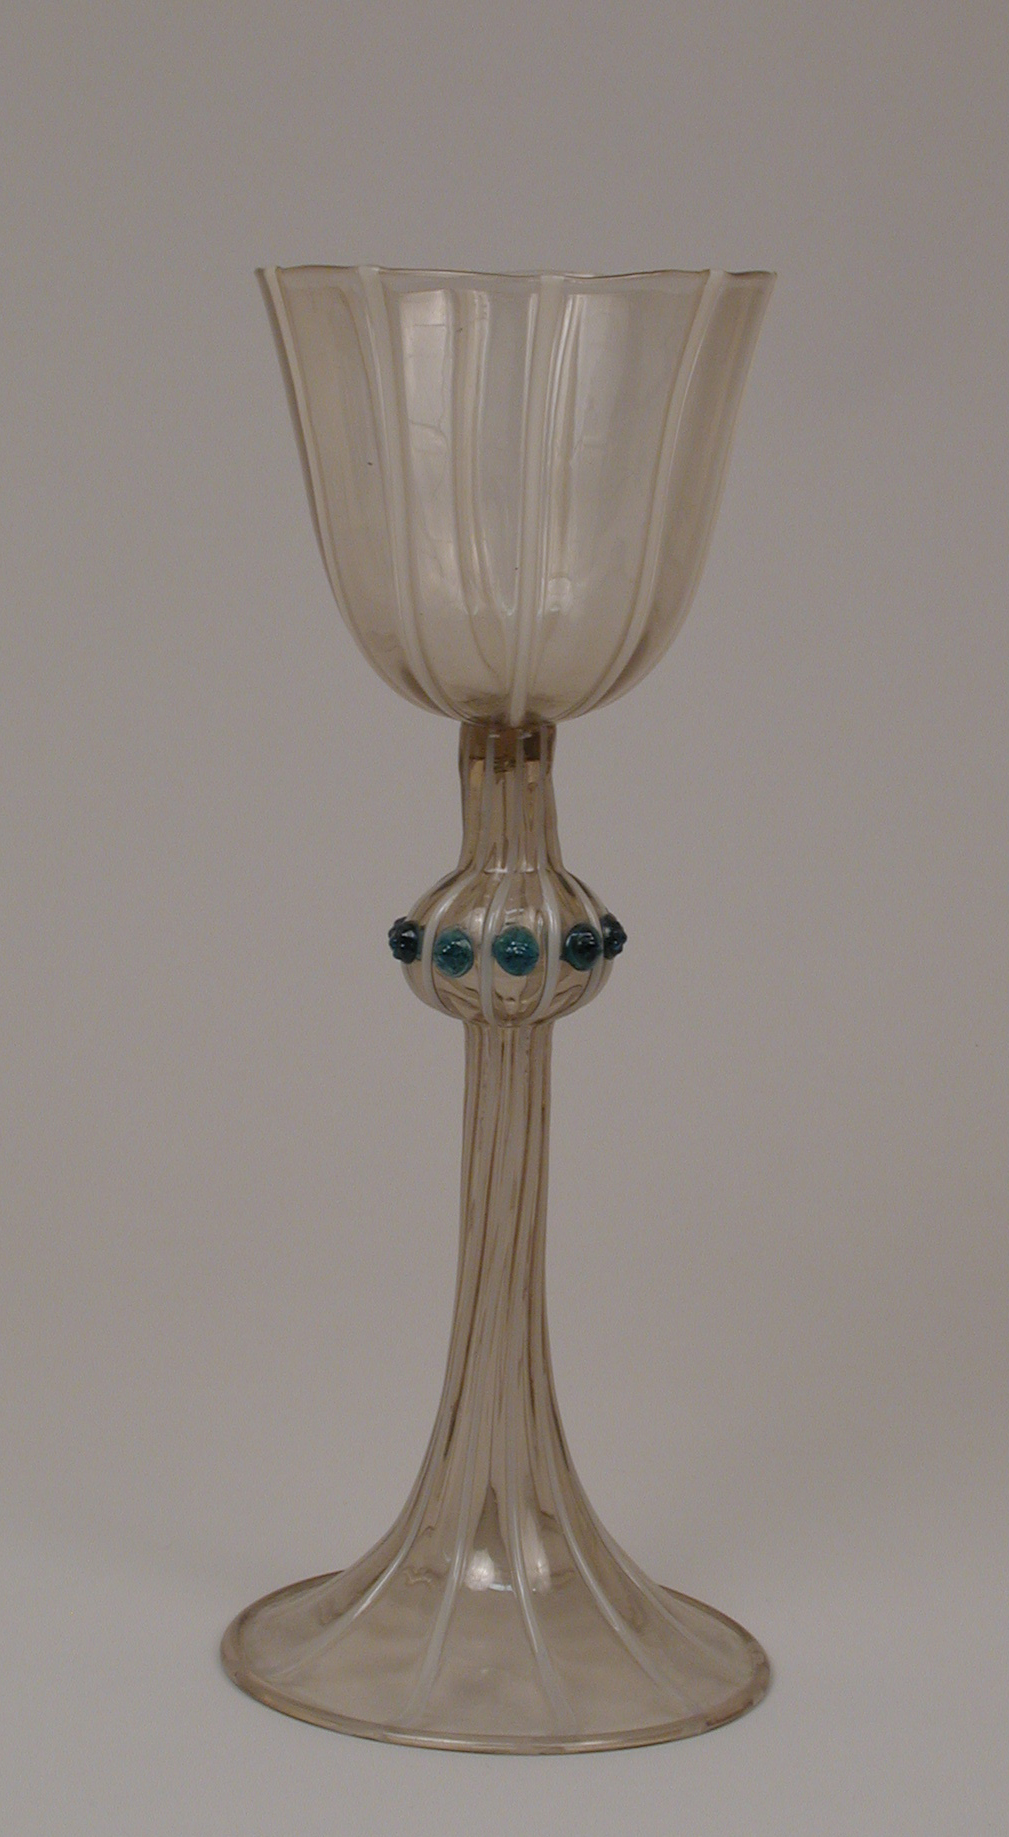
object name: goblet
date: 1801-1900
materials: glass